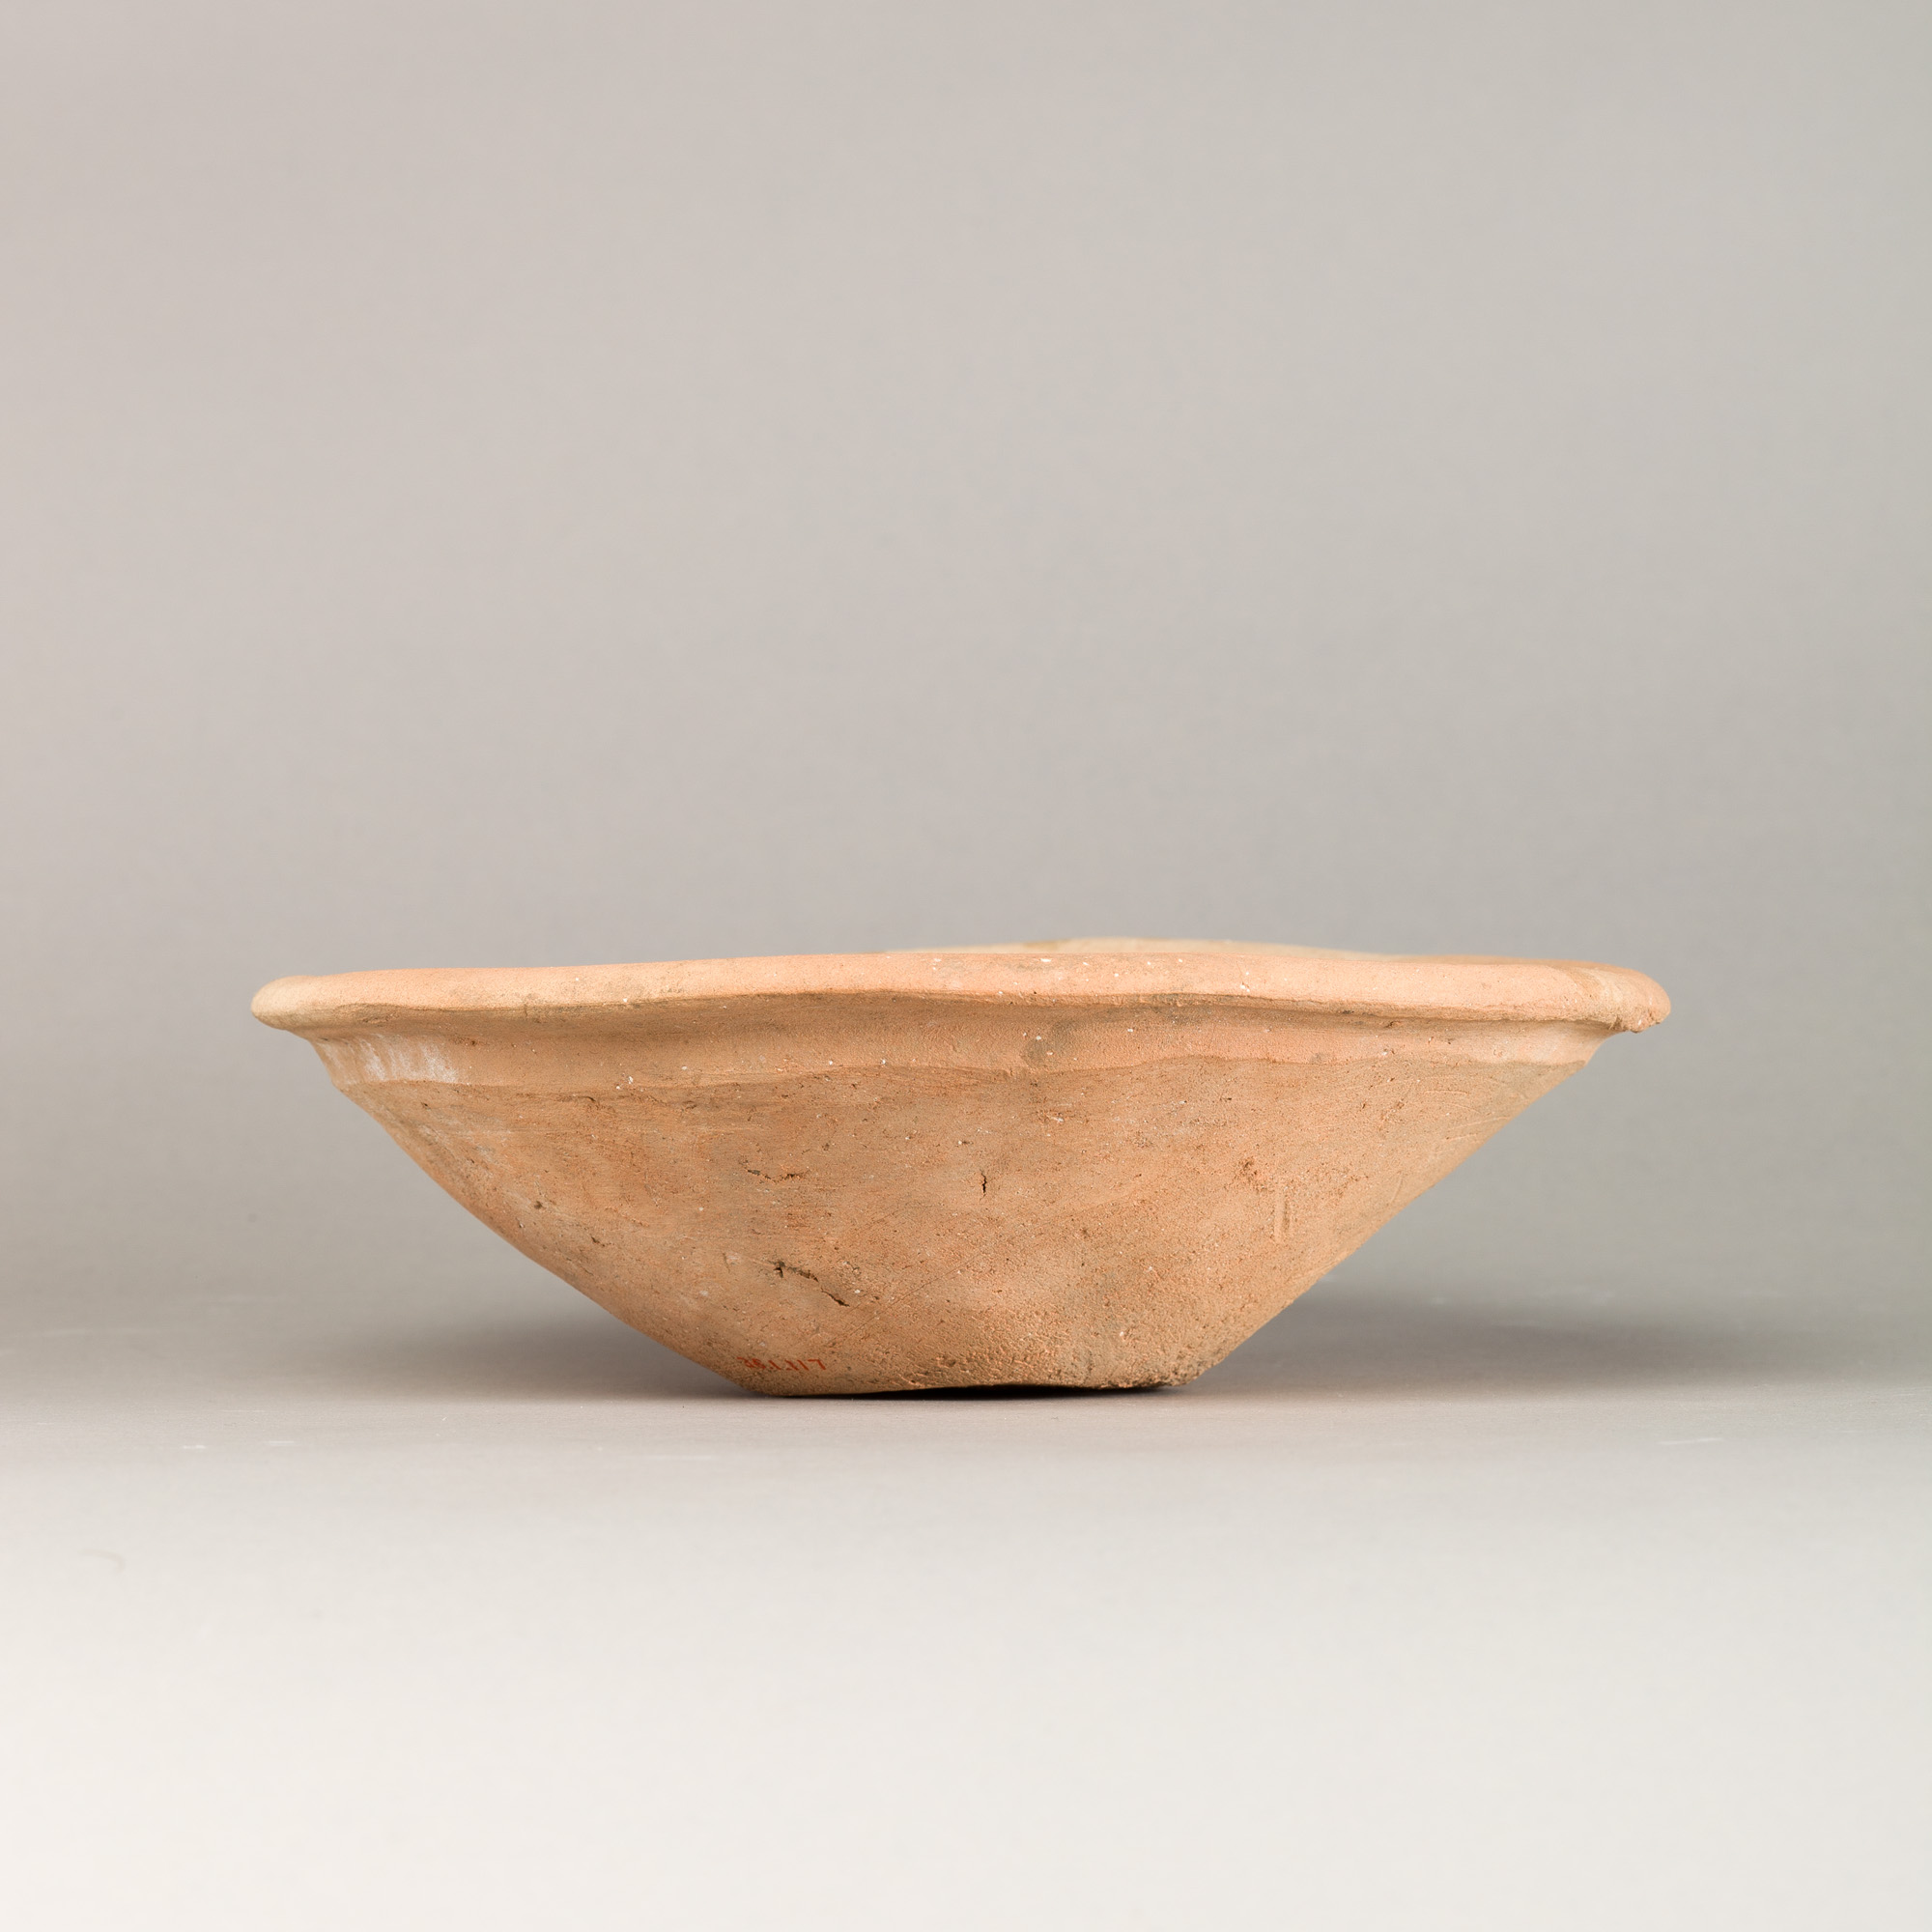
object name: bowl, shallow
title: Bowl with flattened rim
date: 3850-2960 BCE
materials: pottery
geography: egypt